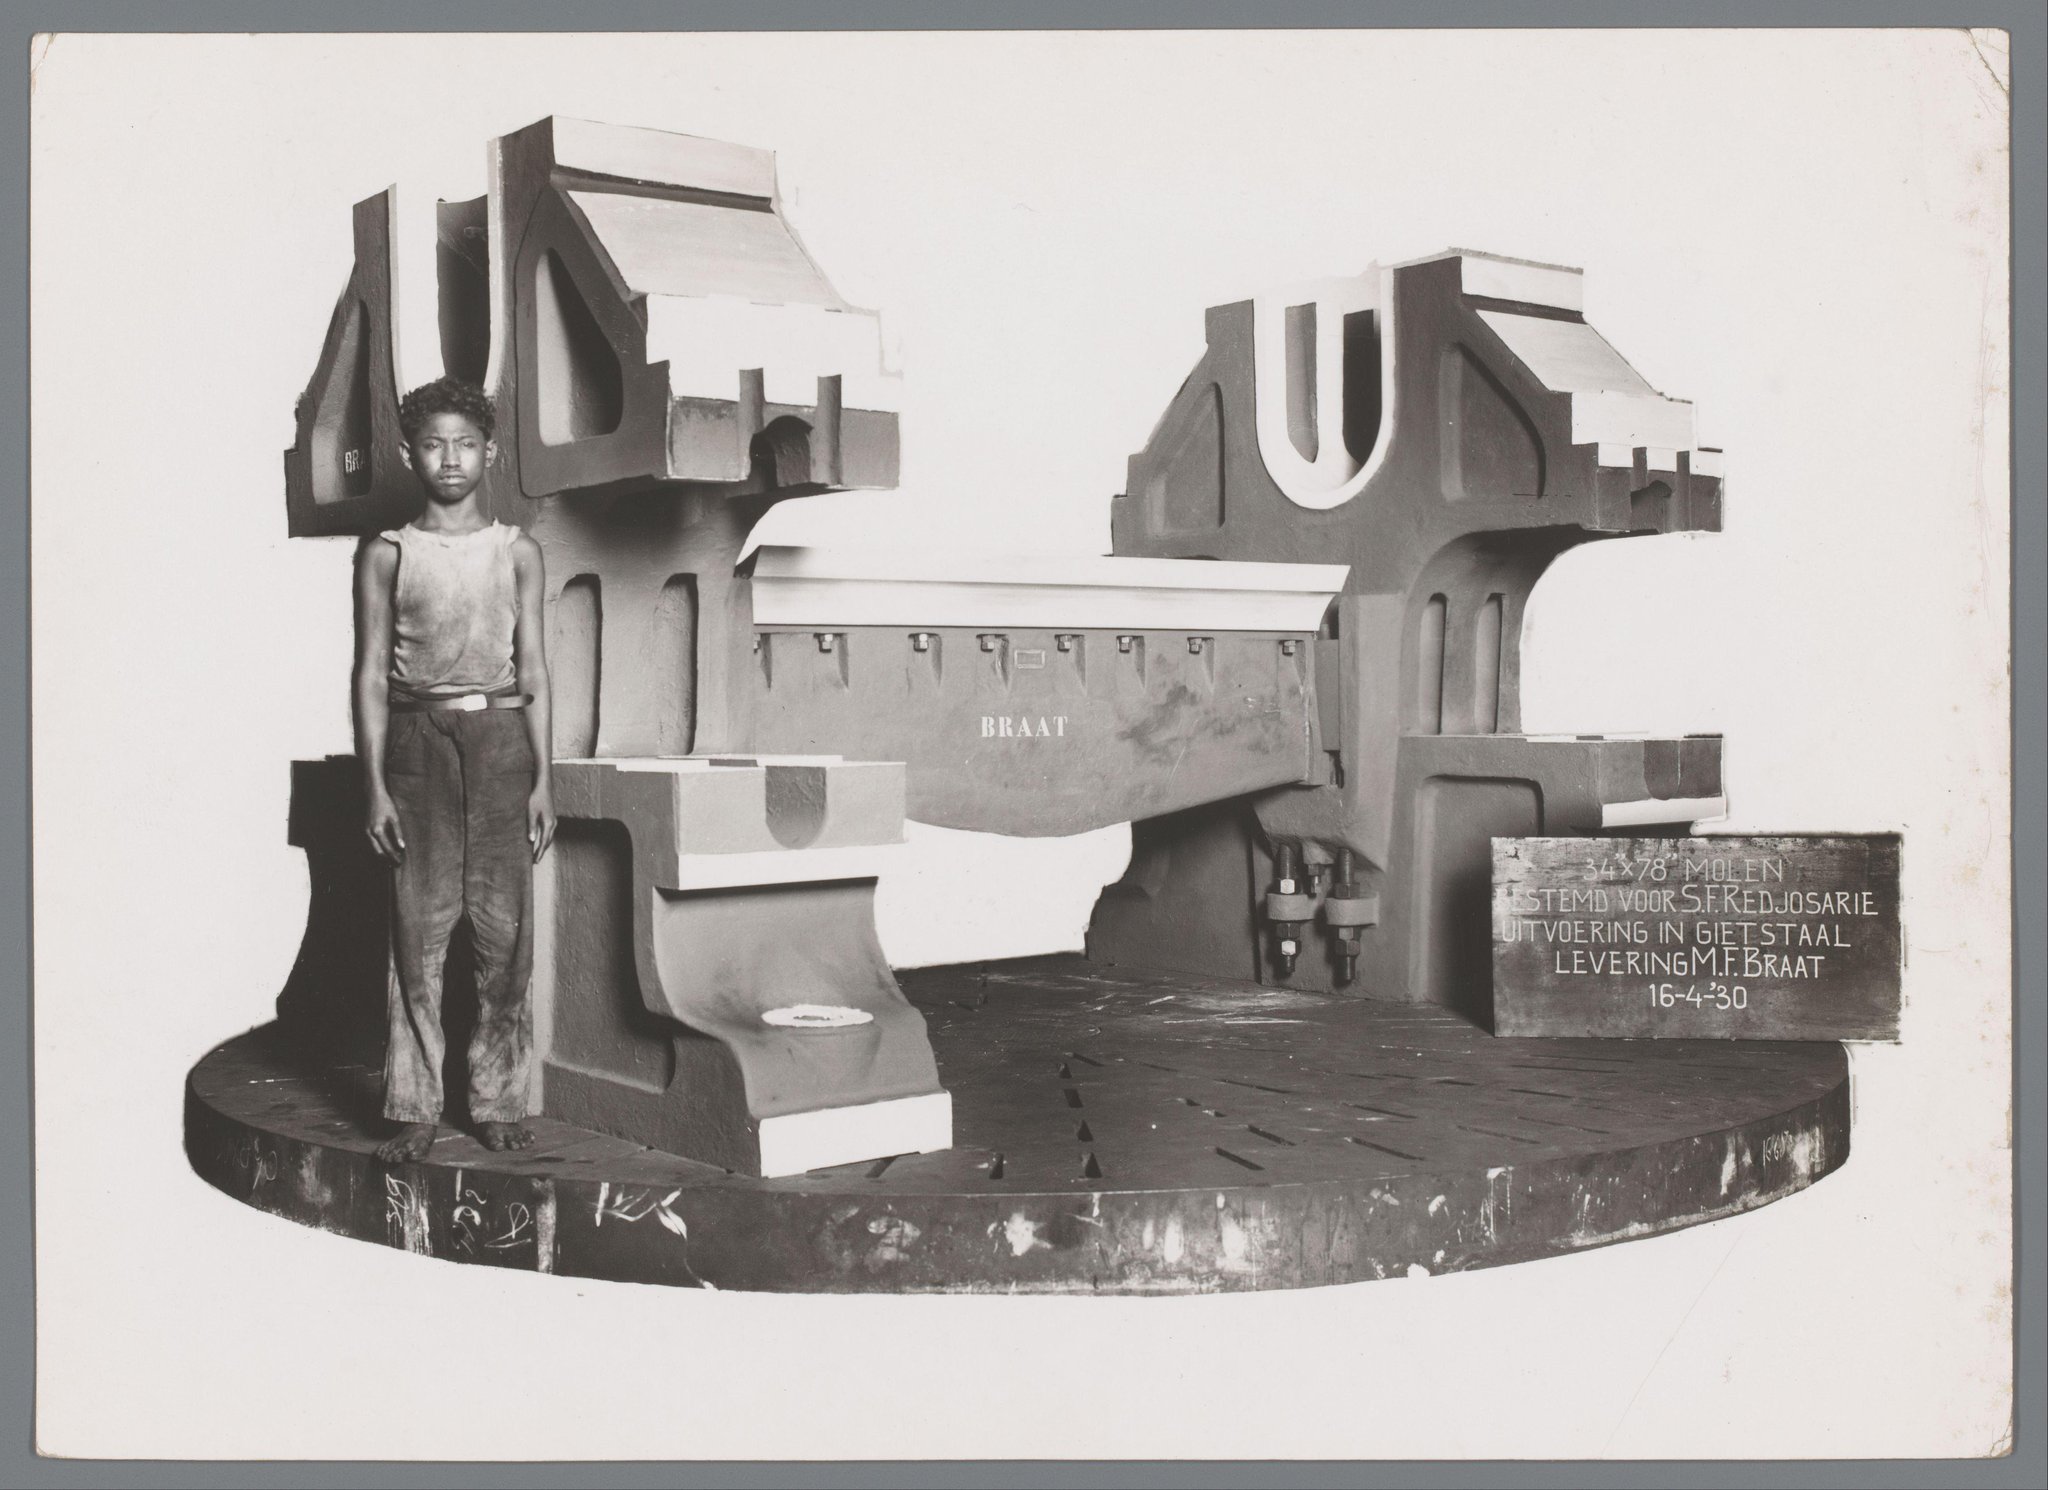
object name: photograph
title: Molenstandaard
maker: Anonymous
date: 1930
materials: photographic support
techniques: gelatin silver print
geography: surabaya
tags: colonial system, machines; parts of machines; tools and appliances, java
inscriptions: date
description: Een gietstalen molenstandaard, vervaardigd in 1930 en bestemd voor Suikerfabriek Redjosarie bij Madioen op Oost-Java. Onderdeel van de multomap met foto's van machines van de N.V. Machinefabriek Braat te Soerabaja, Soekaboemi en Jogyakarta, uit de periode 1908-1942.